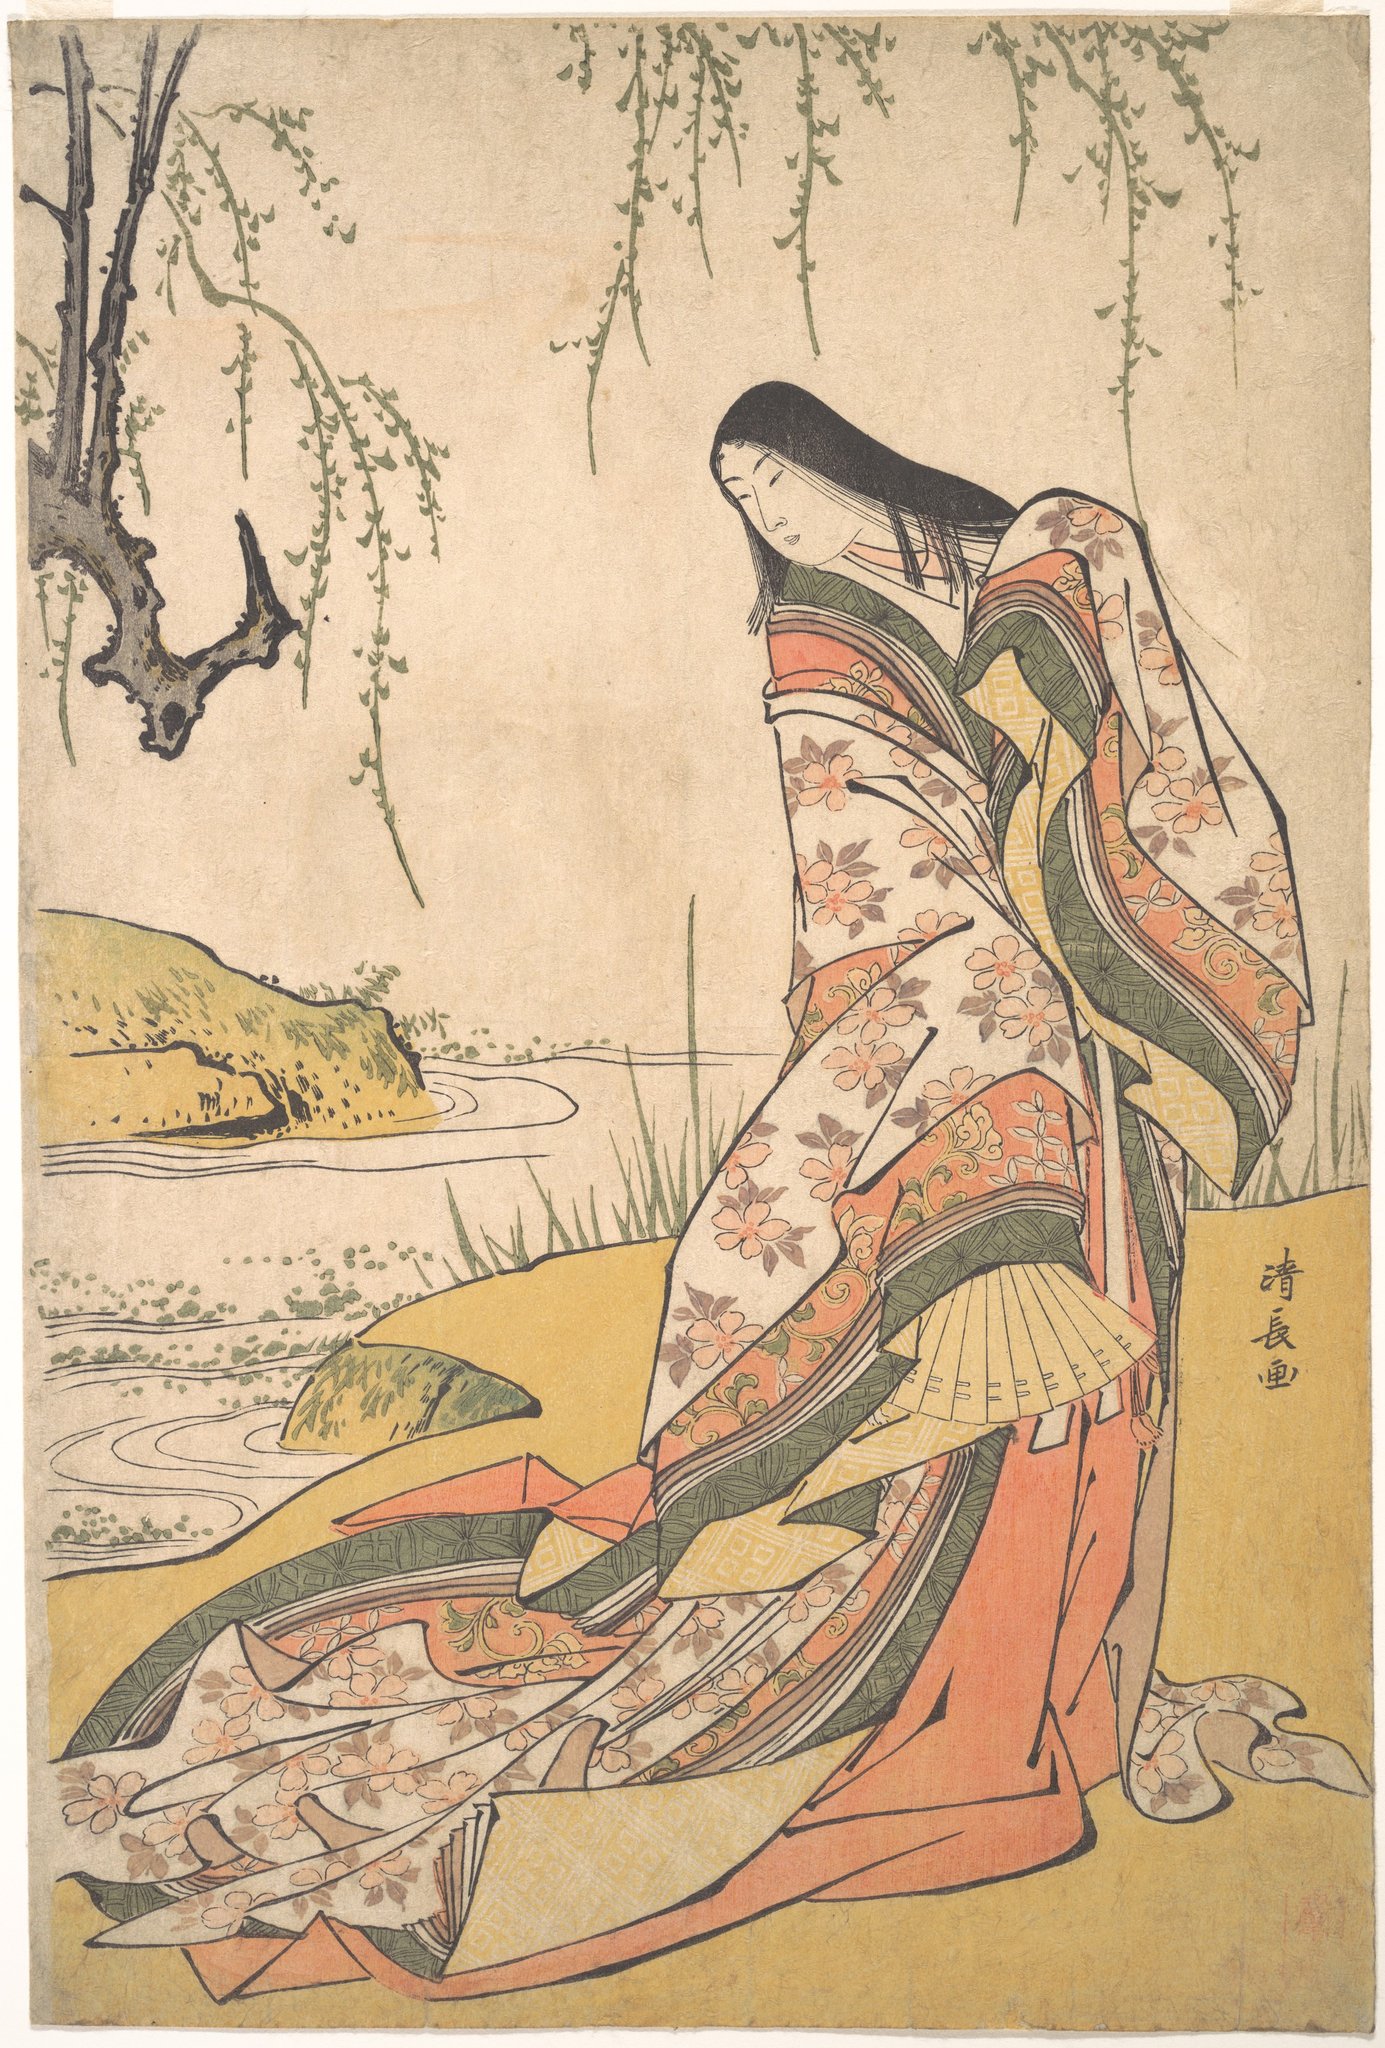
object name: print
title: Kanjo: A Court Lady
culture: japanese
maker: torii kiyonaga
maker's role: artist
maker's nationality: japanese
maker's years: 1752-1815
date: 1790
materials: ink, paper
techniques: woodblock print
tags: women